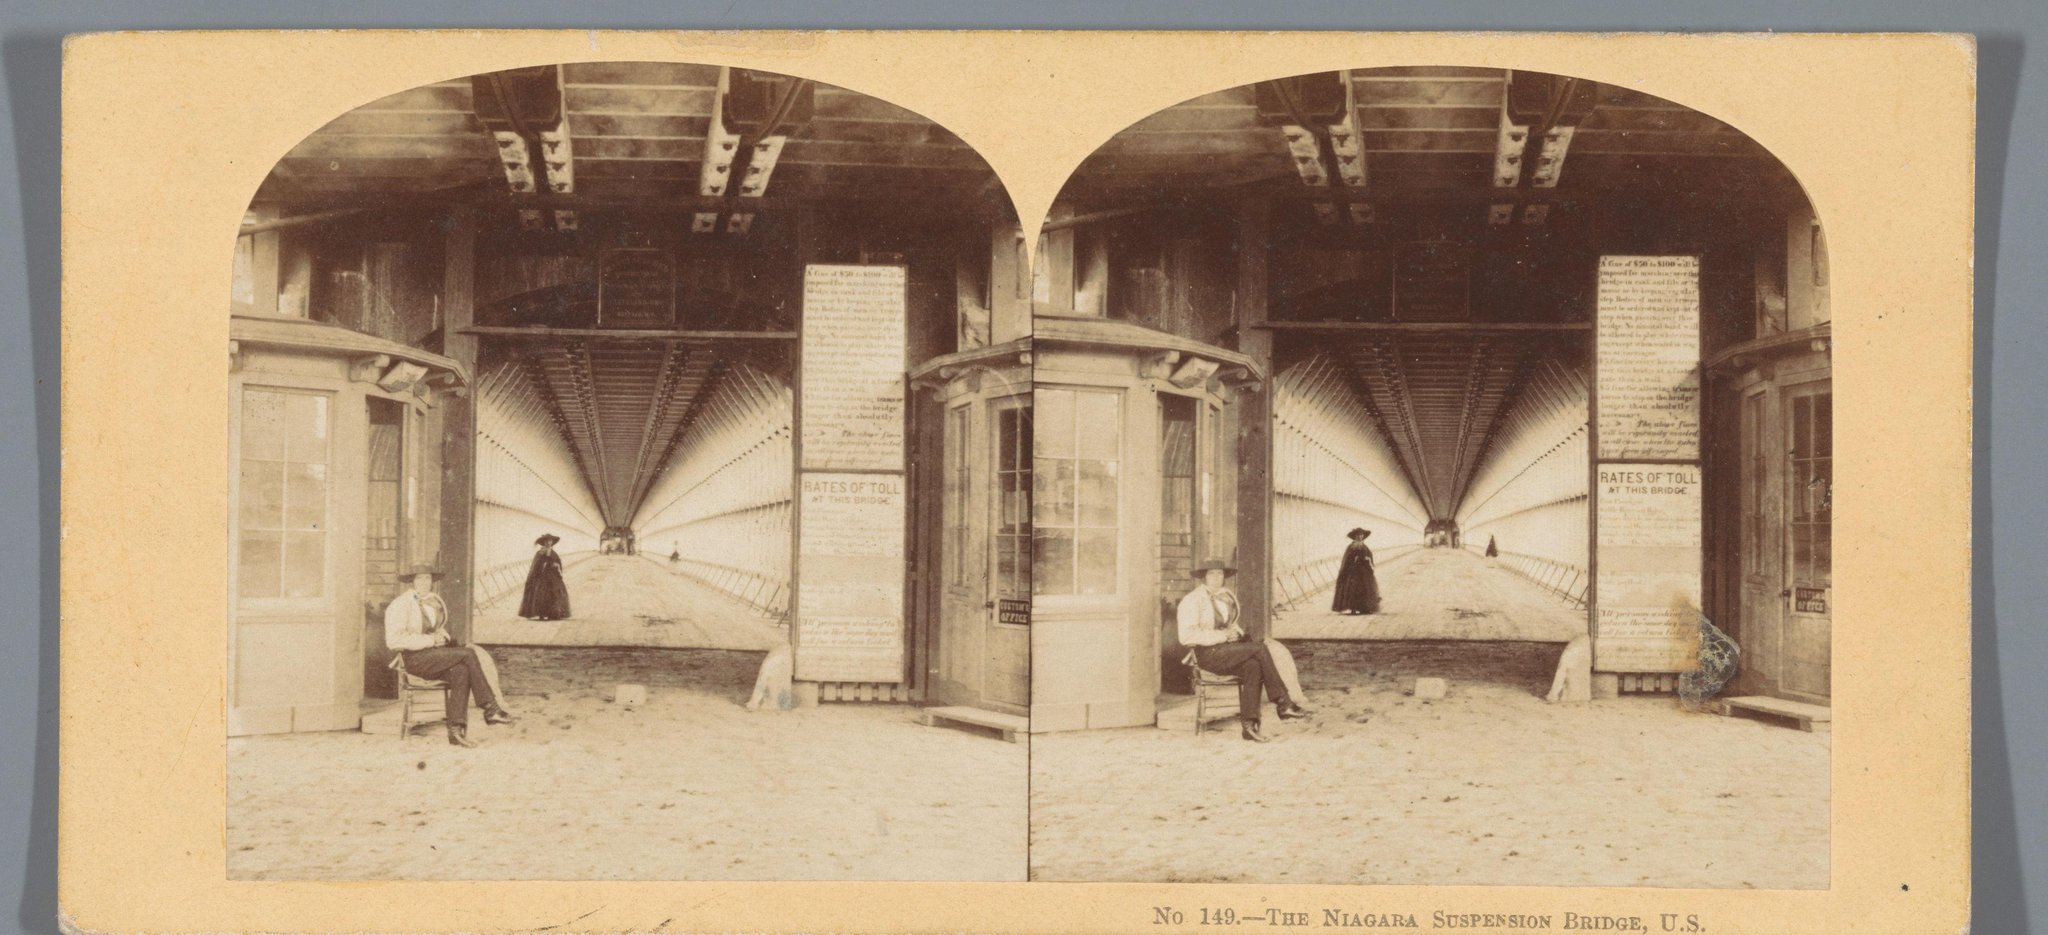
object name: stereograph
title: Ingang en tolheffing aan de Amerikaanse kant van de hangbrug over de Niagarawatervallen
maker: william england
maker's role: fotograaf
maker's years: 1816-1896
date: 1859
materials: cardboard, paper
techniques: albumen print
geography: london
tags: suspension bridge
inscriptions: number: ‘152’, stamp: ‘Nolet & Zoon’, number: ‘No 149’, : ‘This bridge (...) twenty-five cents.’